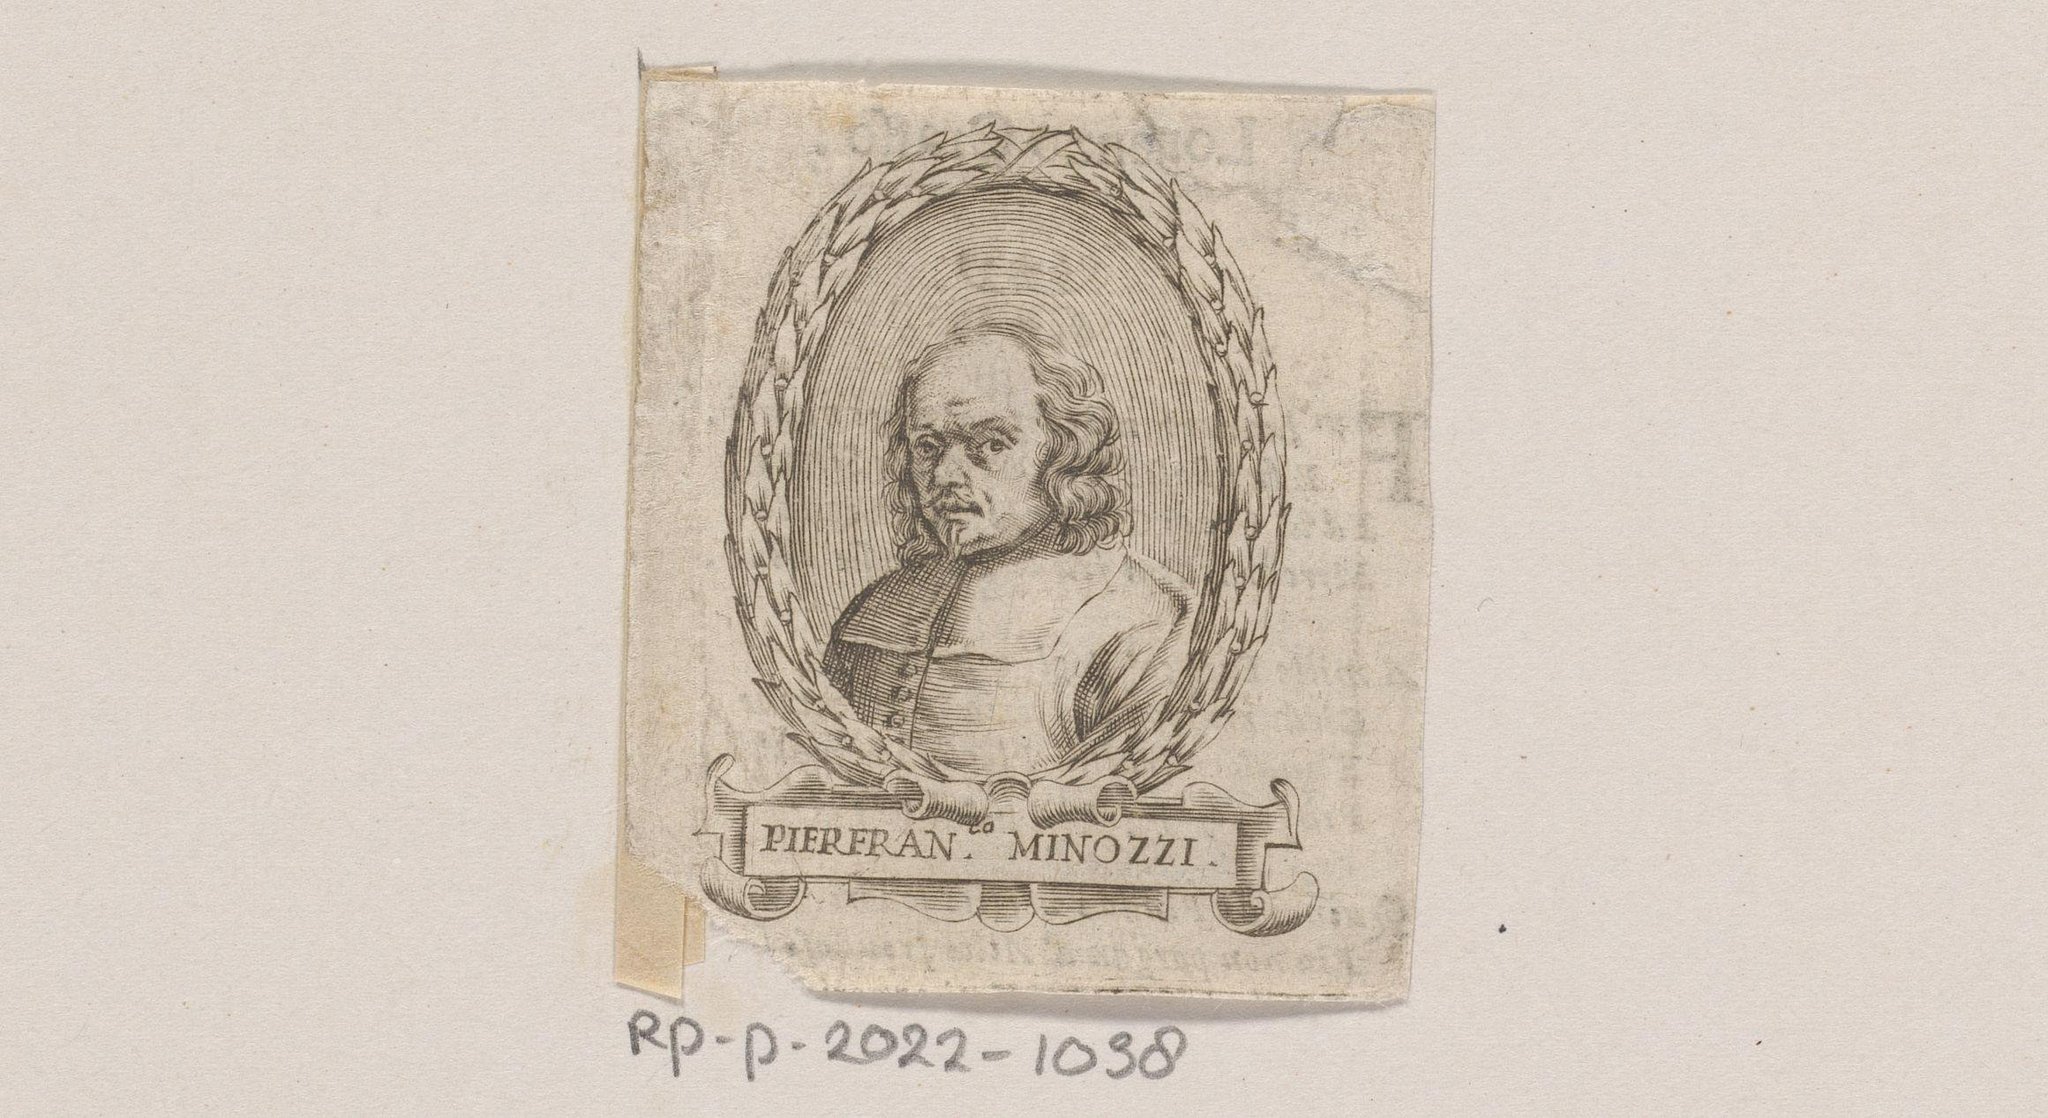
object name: print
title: Portret van Pier Francesco Minozzi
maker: Anonymous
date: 1667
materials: paper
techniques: engraving, letterpress printing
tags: pier francesco minozzi, historical persons, portrait of a writer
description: Prent uit: Bonomi, Giovanni Francesco. Del parto dell'orsa idee in embrione di Giouanfrancesco Bonomi bolognese. Bologna: s.n., 1667, dl. 2.